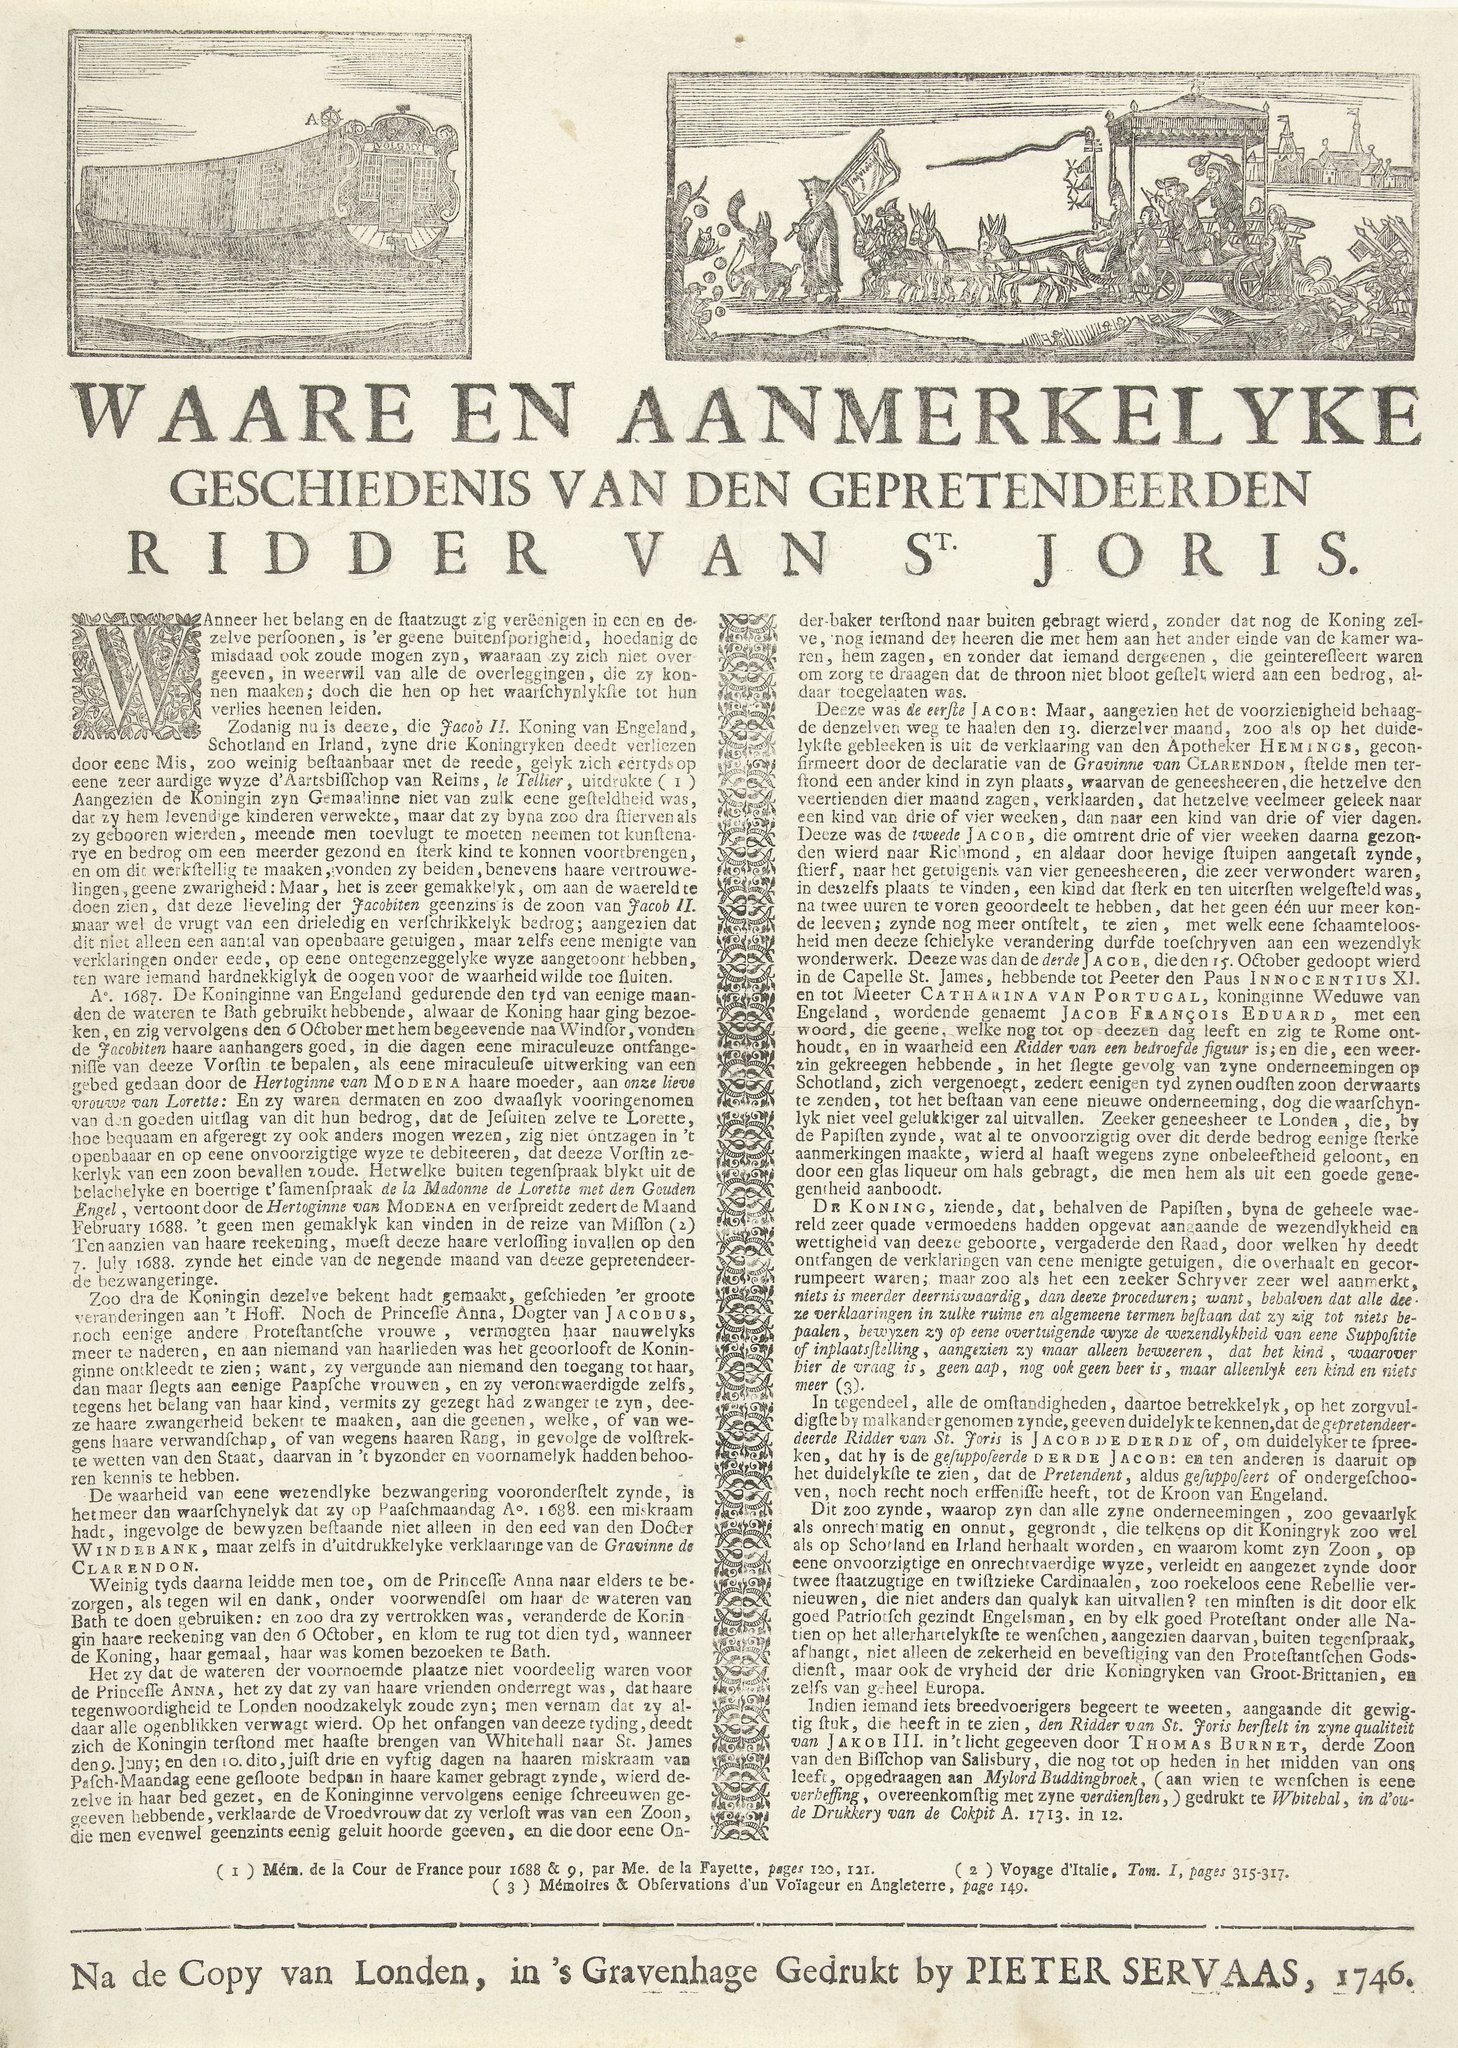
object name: print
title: Spotprent op de opstand van de jonge pretendent, 1746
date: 1746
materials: paper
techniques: letterpress printing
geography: england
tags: ships (in general) (+ propulsion of vehicle, ship, etc. by animals), regular clerics, e.g. jesuits, redemptorists, political caricatures and satires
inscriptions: collector's mark: Lugt 2228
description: Spotprent op het mislukken van de Tweede Jacobitische Opstand in 1746. Blad met tekst en twee voorstellingen. Rechts de strijdwagen van de jonge prentendent Karel Eduard Stuart getrokken door ezels en voorafgegaan door een bisschop op een varken en een jezuïet met een vaandel van de Inquisitie. Links een schip zonder zeilen met de naam: Volg My (het Vliegende Vaartuig van Daam Schijf). Op het blad een beschrijving van de gebeurtenissen in twee kolommen.